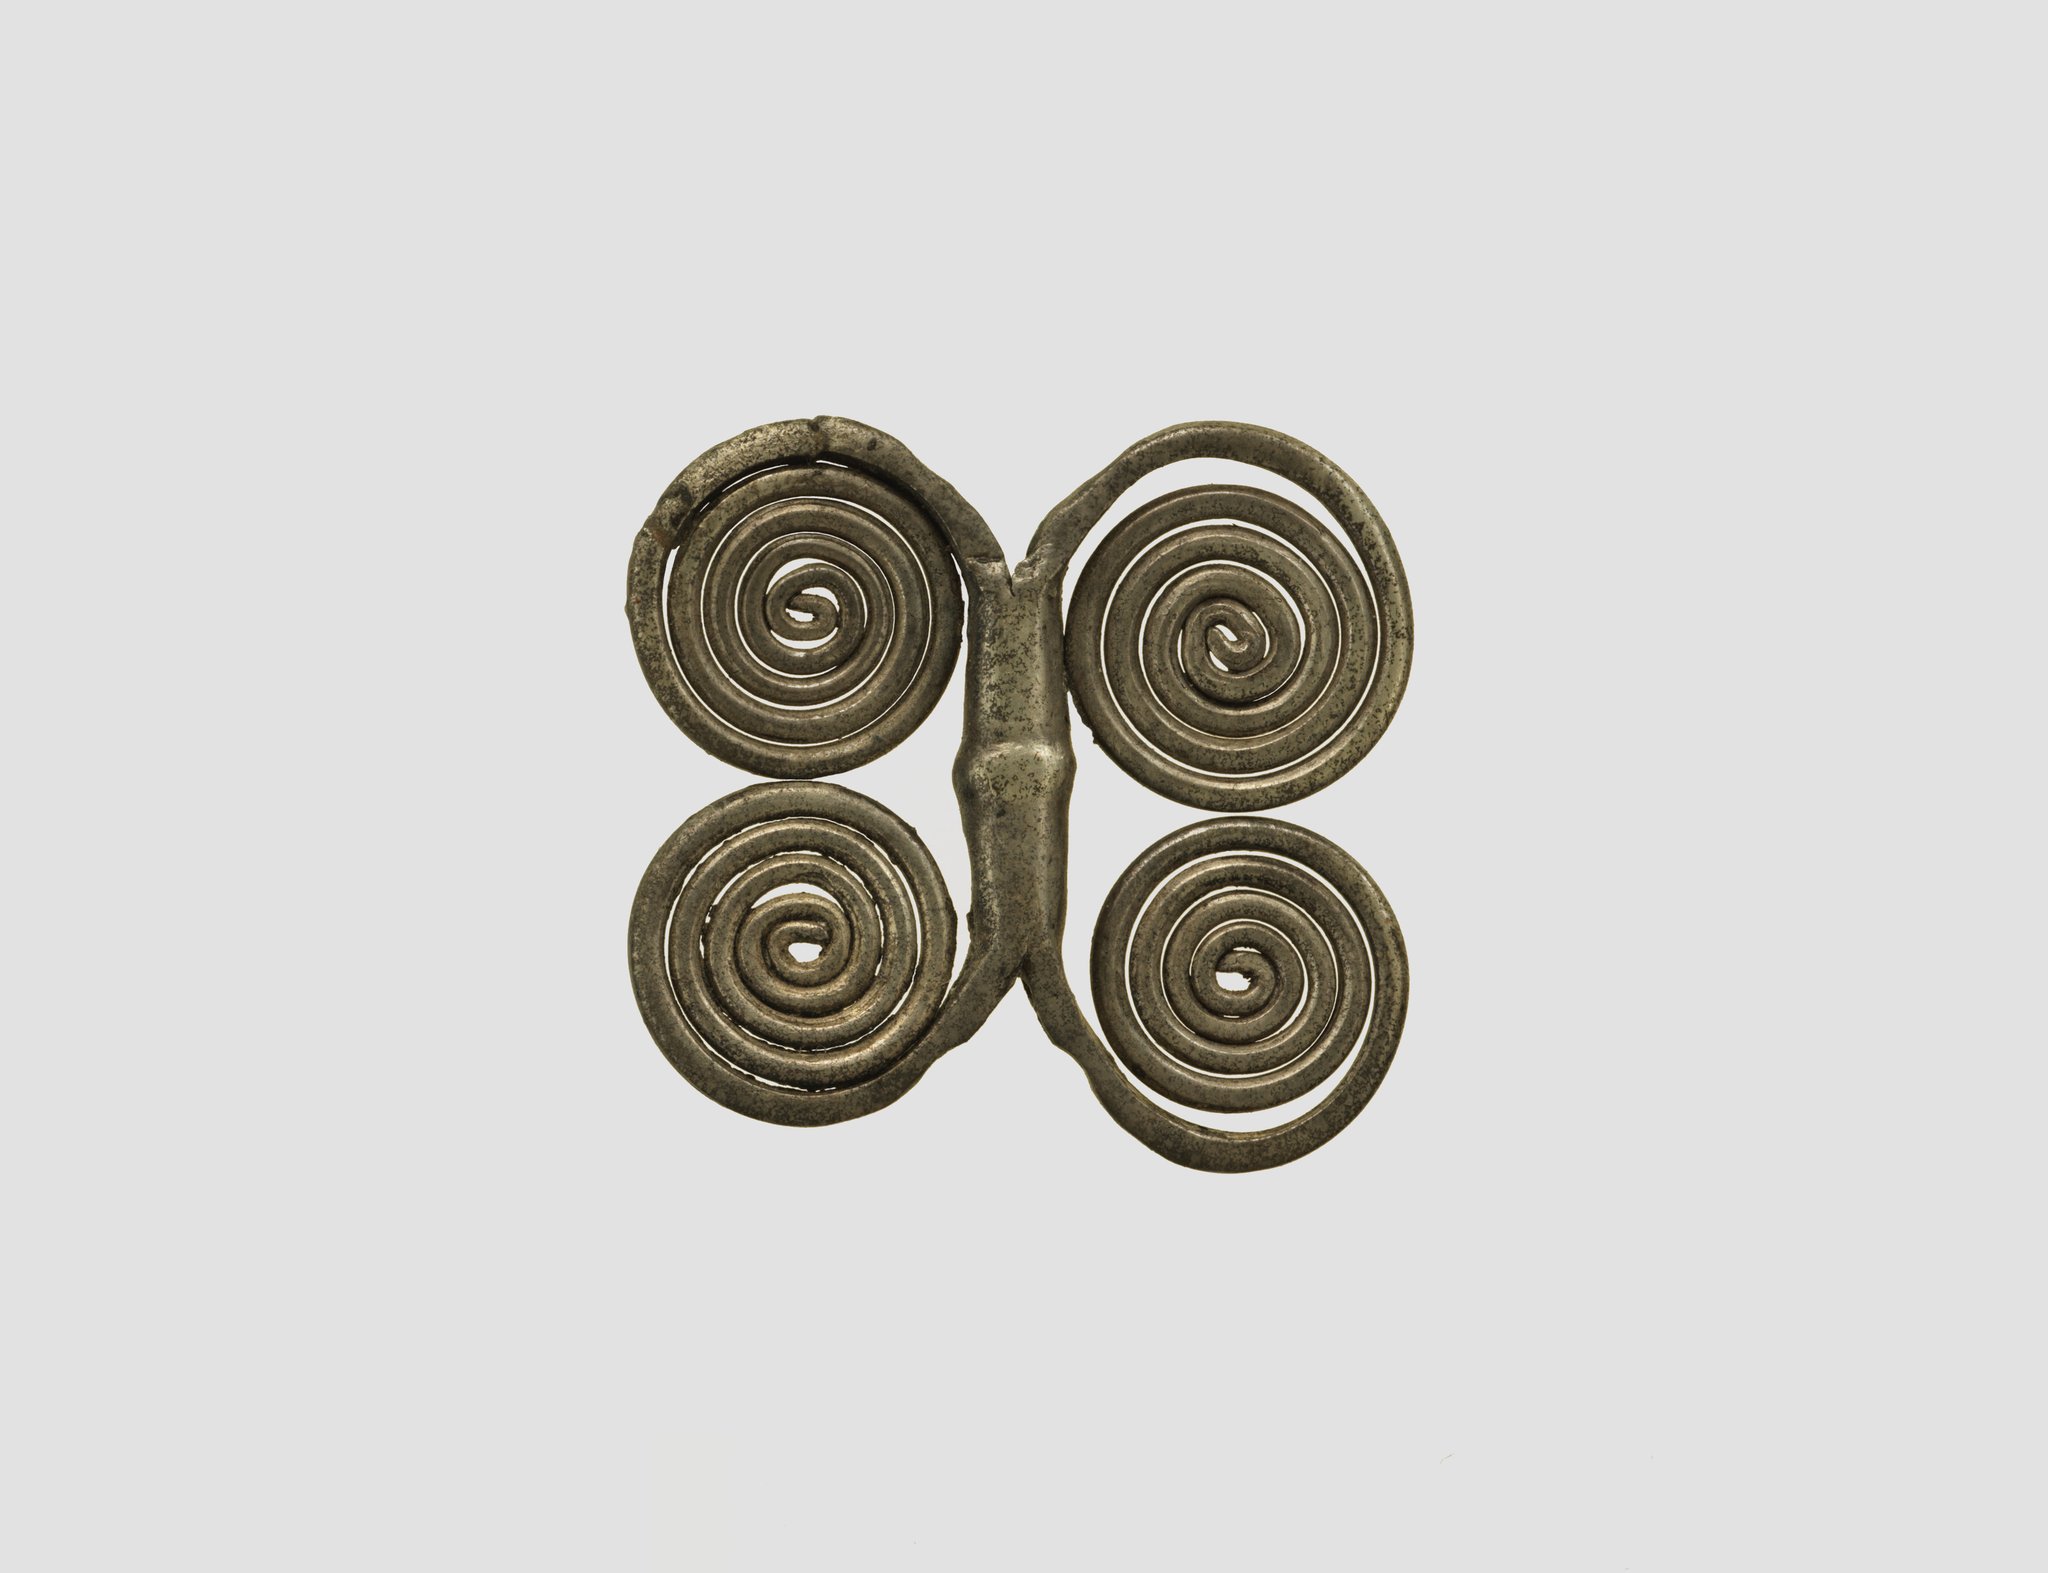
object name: bead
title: Spiral bead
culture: iranian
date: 2333-1668 BCE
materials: silver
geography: iran